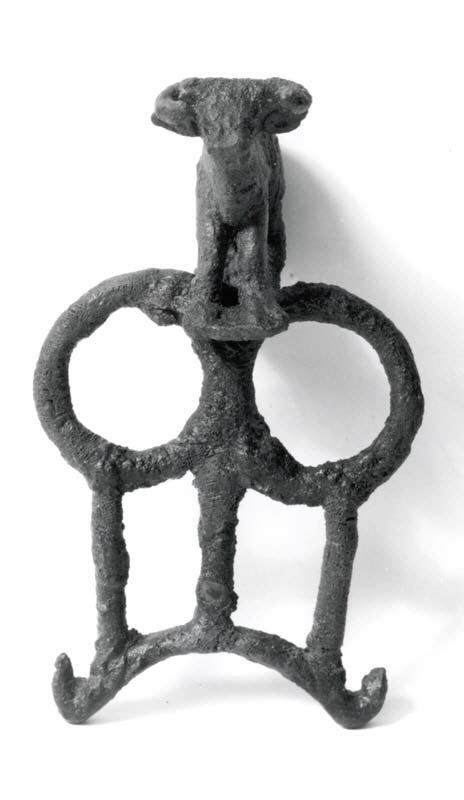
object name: harness ring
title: Harness ring surmounted by bull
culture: sumerian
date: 2600-2350 BCE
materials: copper alloy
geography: mesopotamia